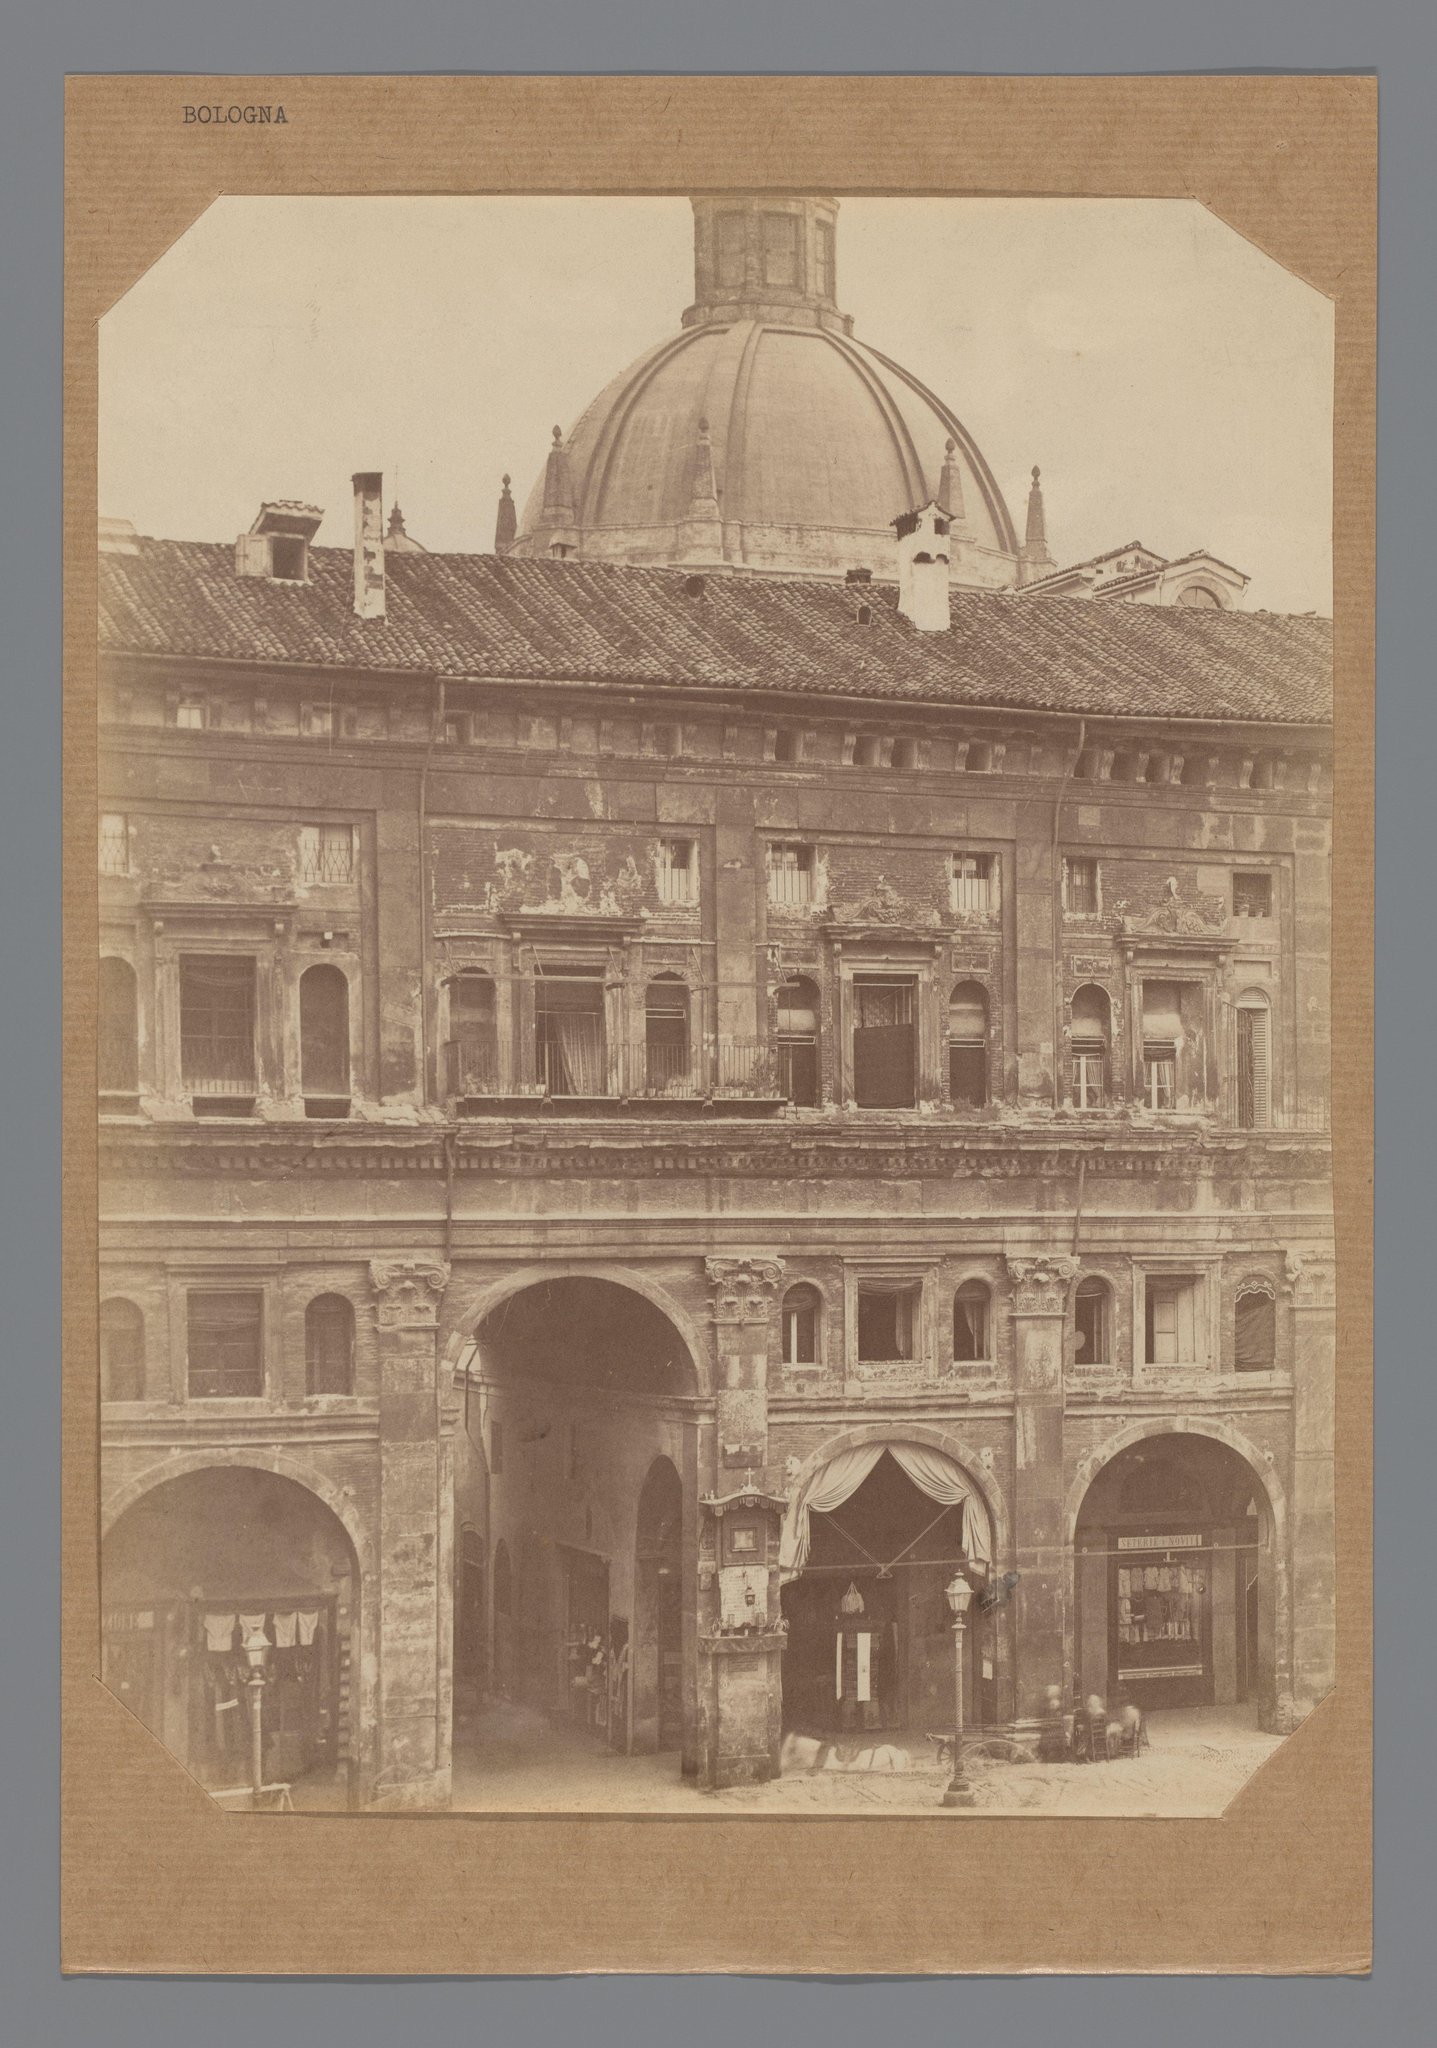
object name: photograph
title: Italië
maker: Anonymous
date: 1880-1910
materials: photographic support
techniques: albumen print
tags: italy